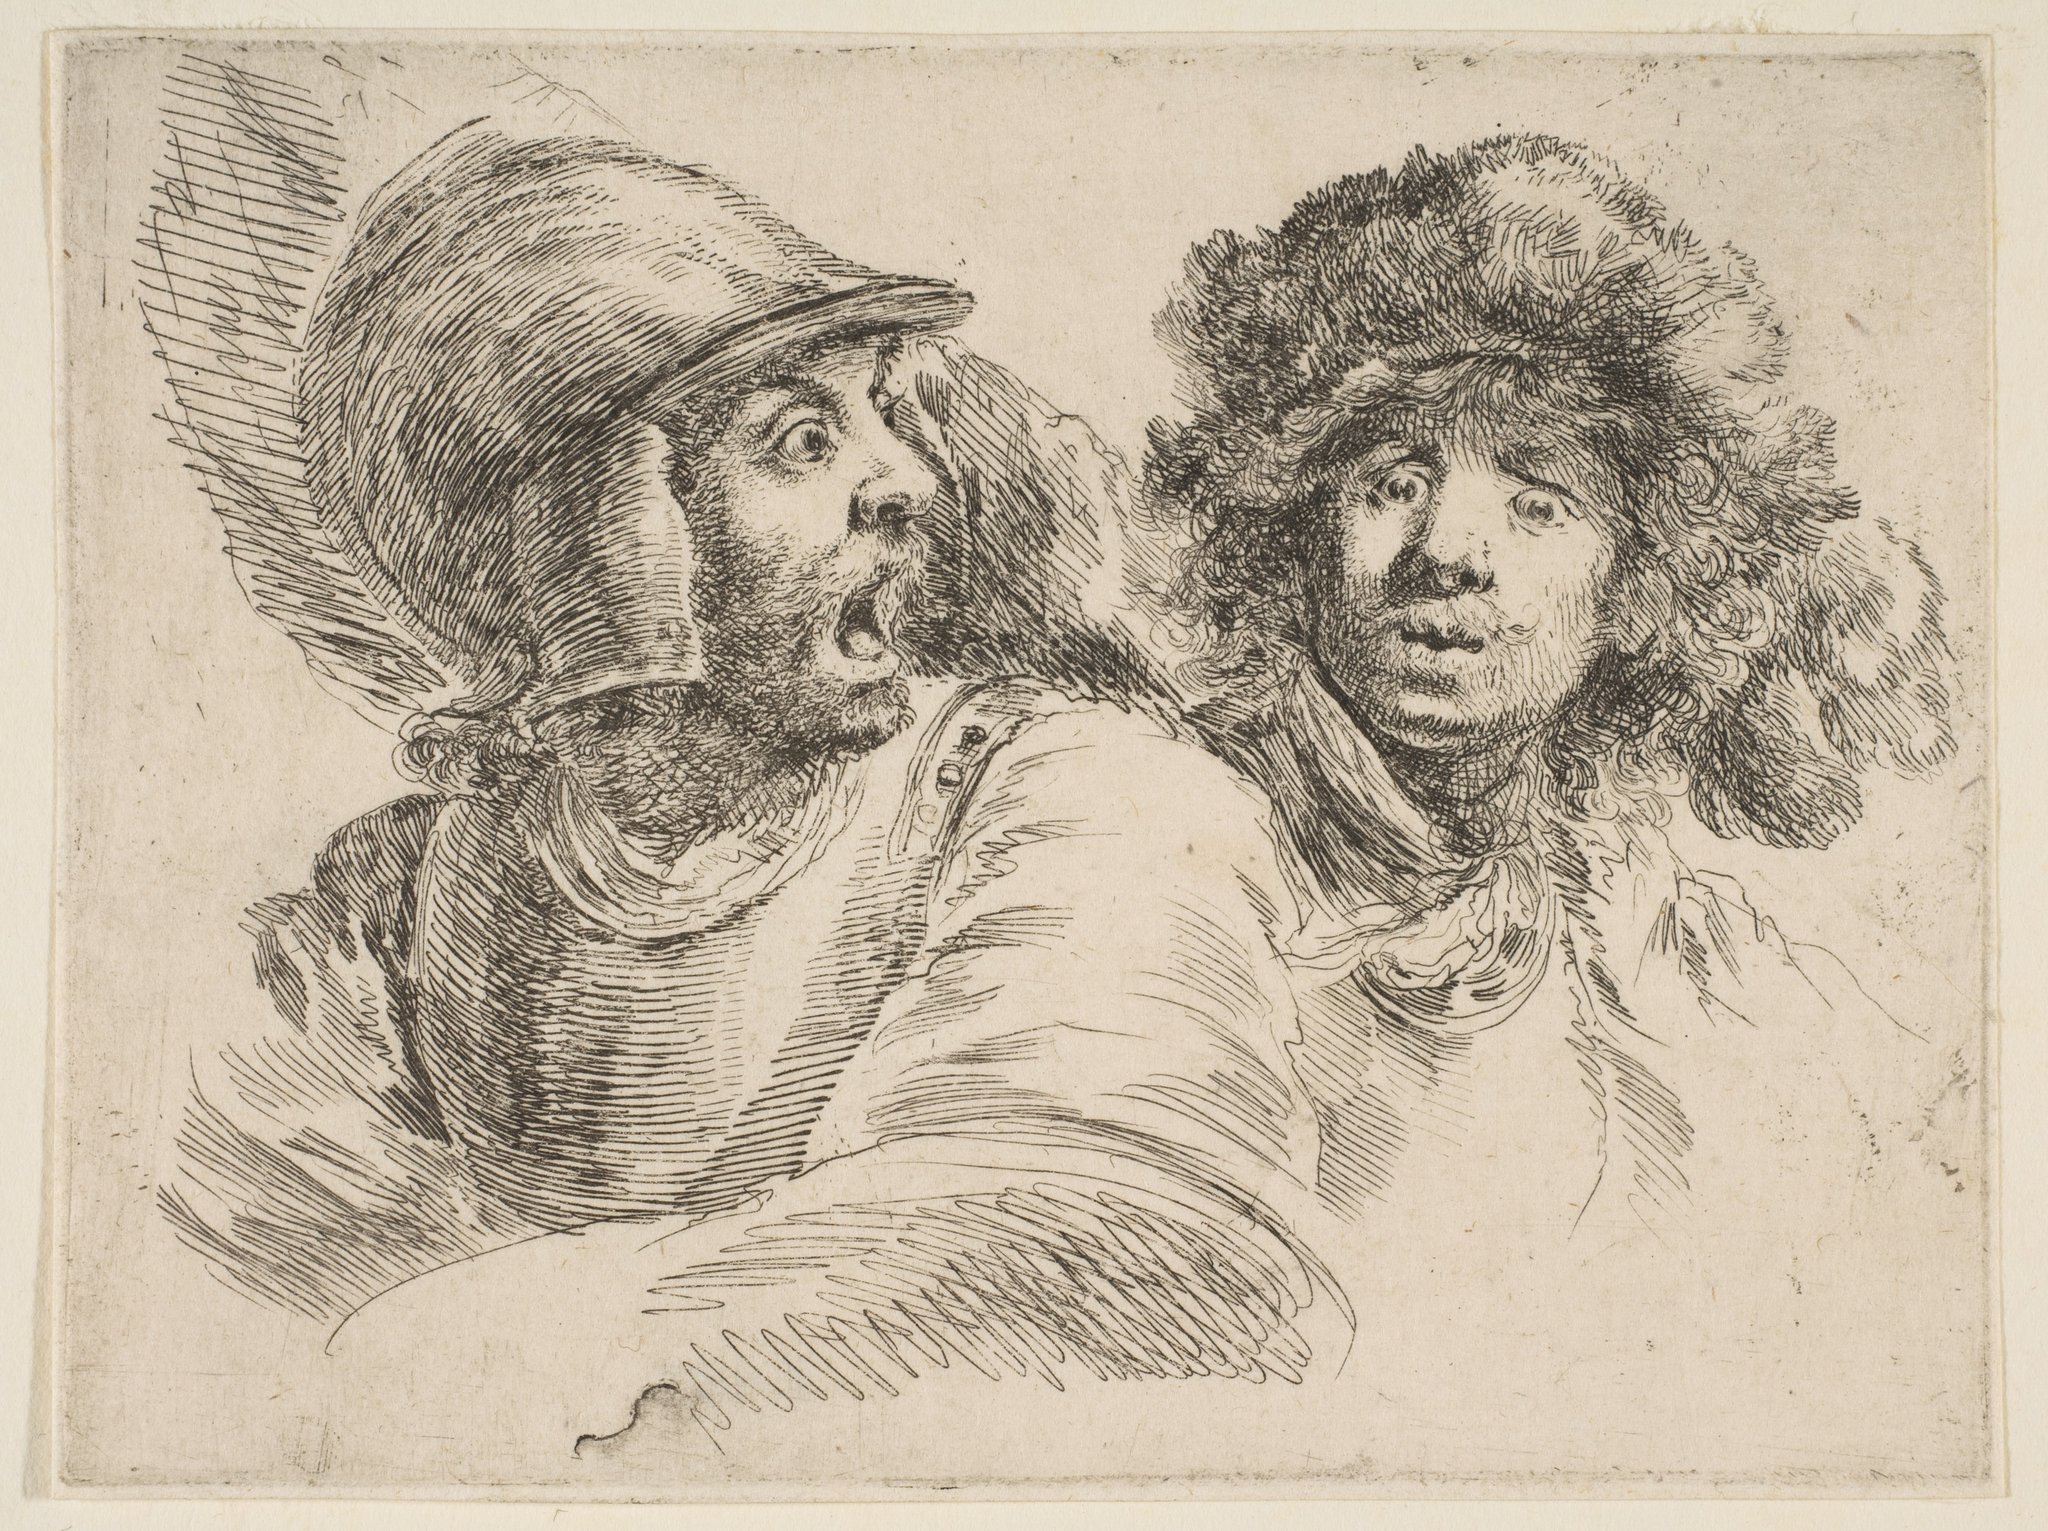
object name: print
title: Frightened Soldier and a Man in a Fur Hat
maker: stefano della bella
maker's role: artist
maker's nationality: italian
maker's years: 1610-1664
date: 1652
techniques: etching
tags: soldiers,fear,men